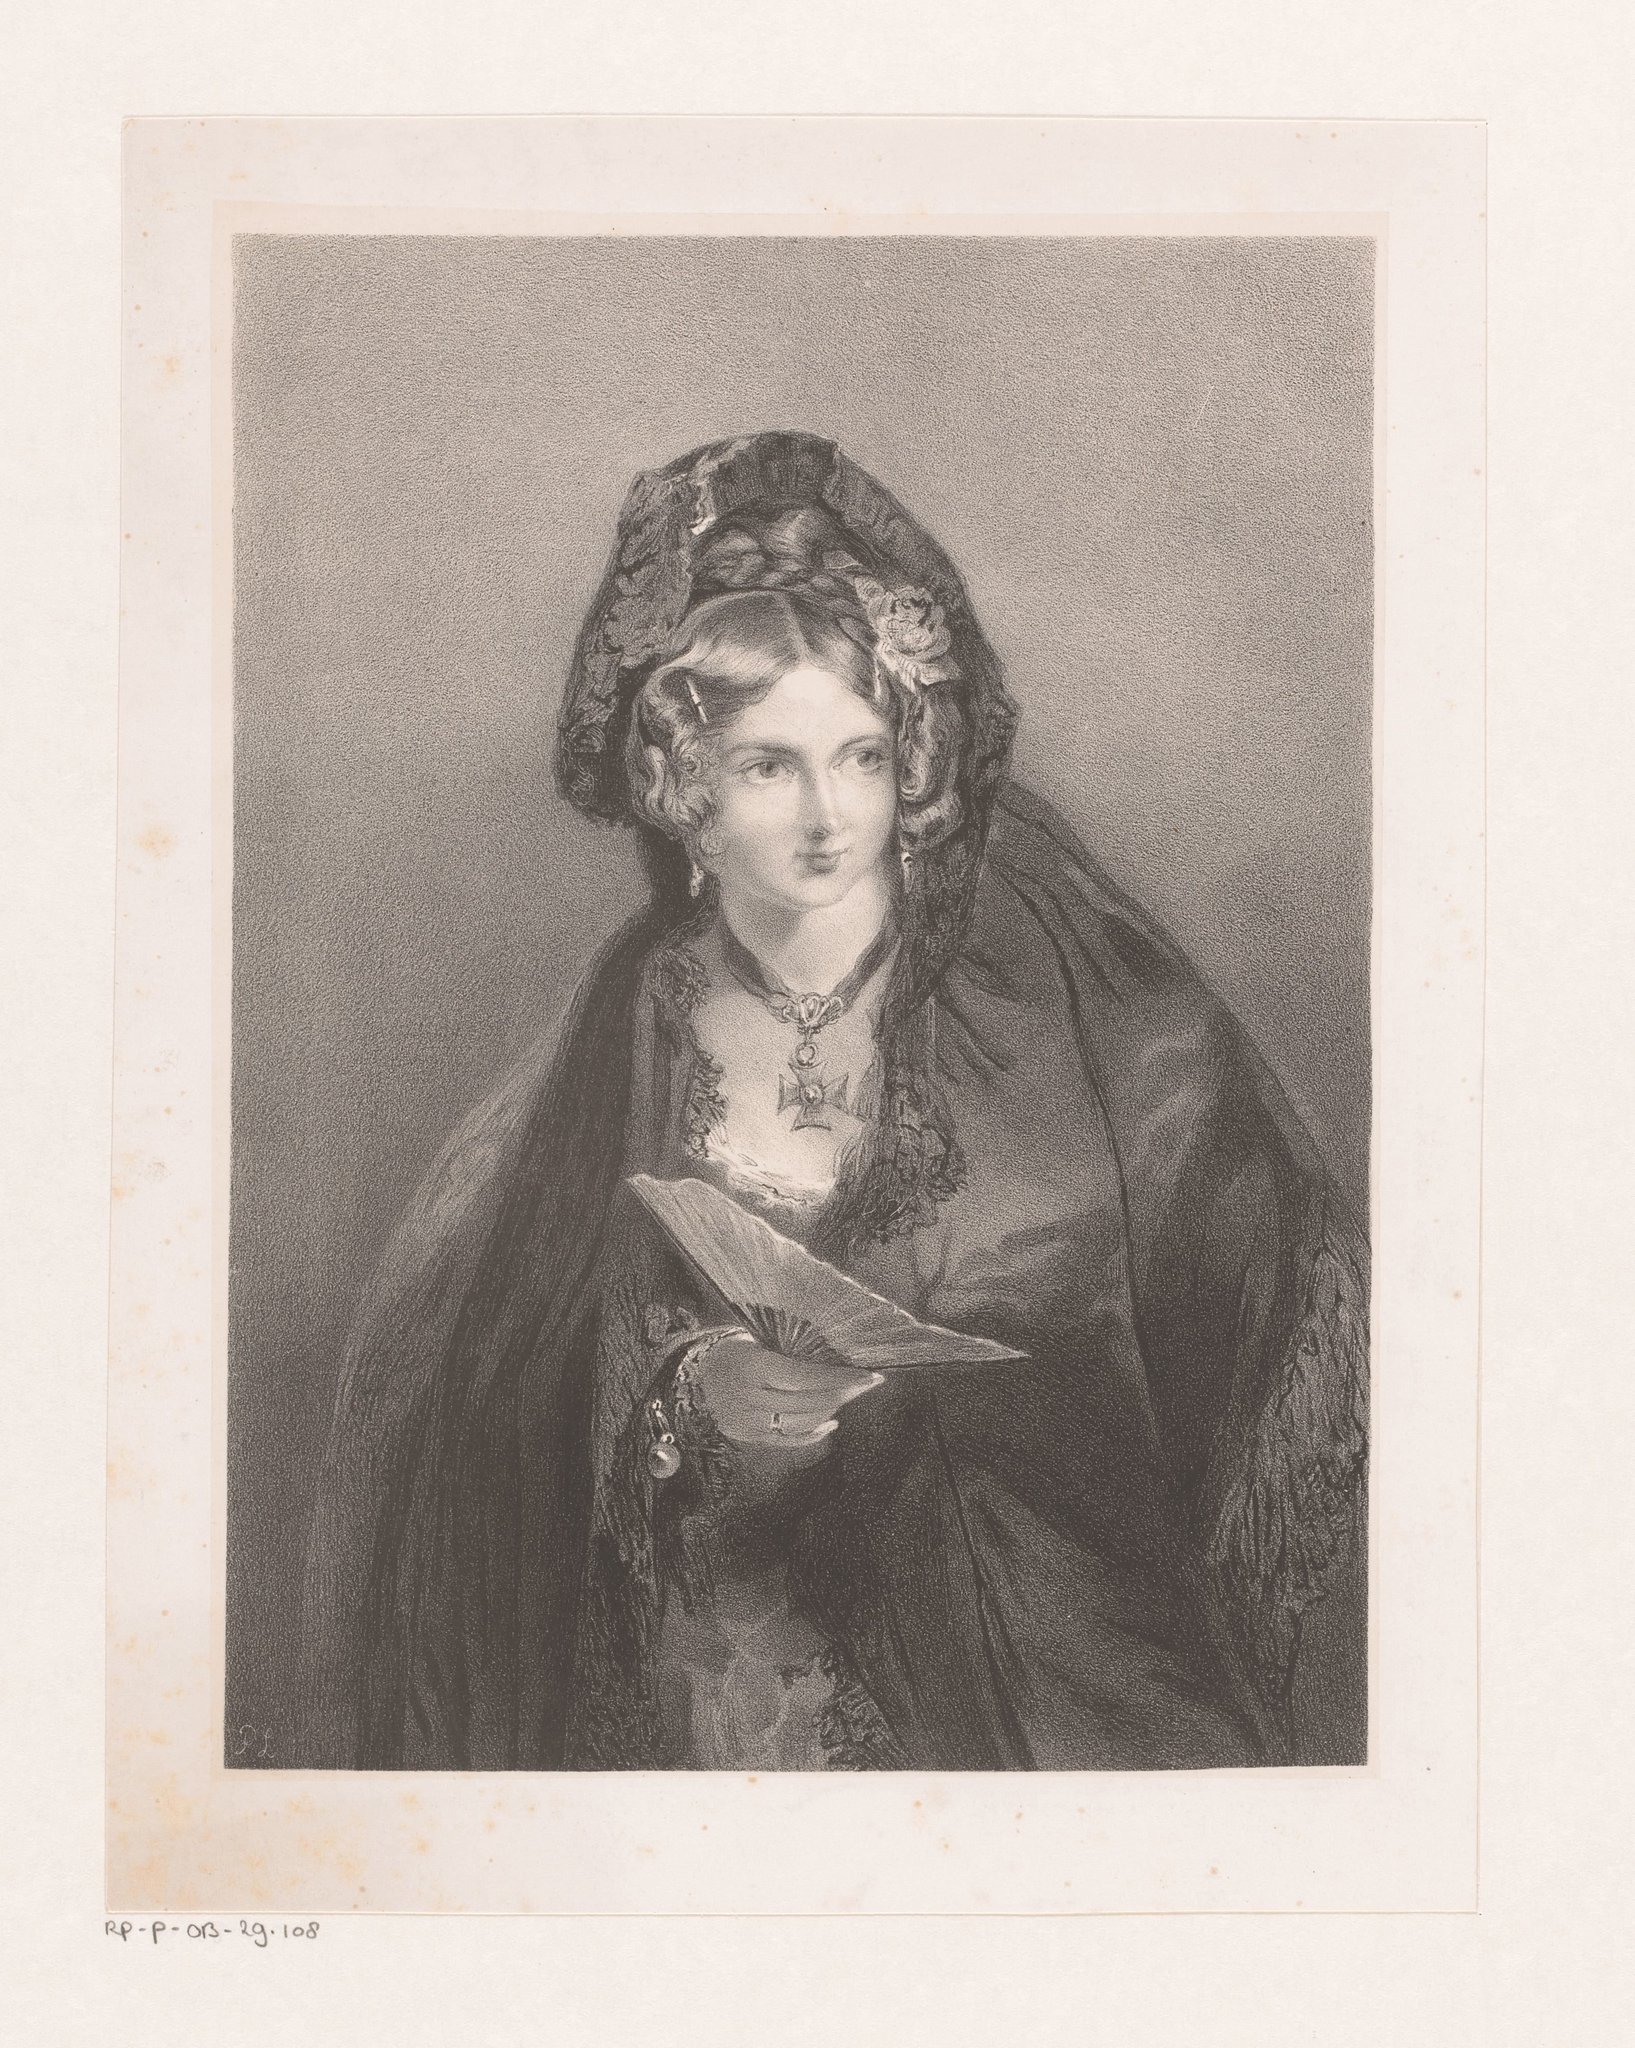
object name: print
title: Jonge vrouw met omslagdoek en waaier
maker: paulus anthonius liernur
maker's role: print maker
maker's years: 1826-1857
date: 1836-1857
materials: paper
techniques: lithograph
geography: the hague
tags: fan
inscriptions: collector's mark: Lugt 2228